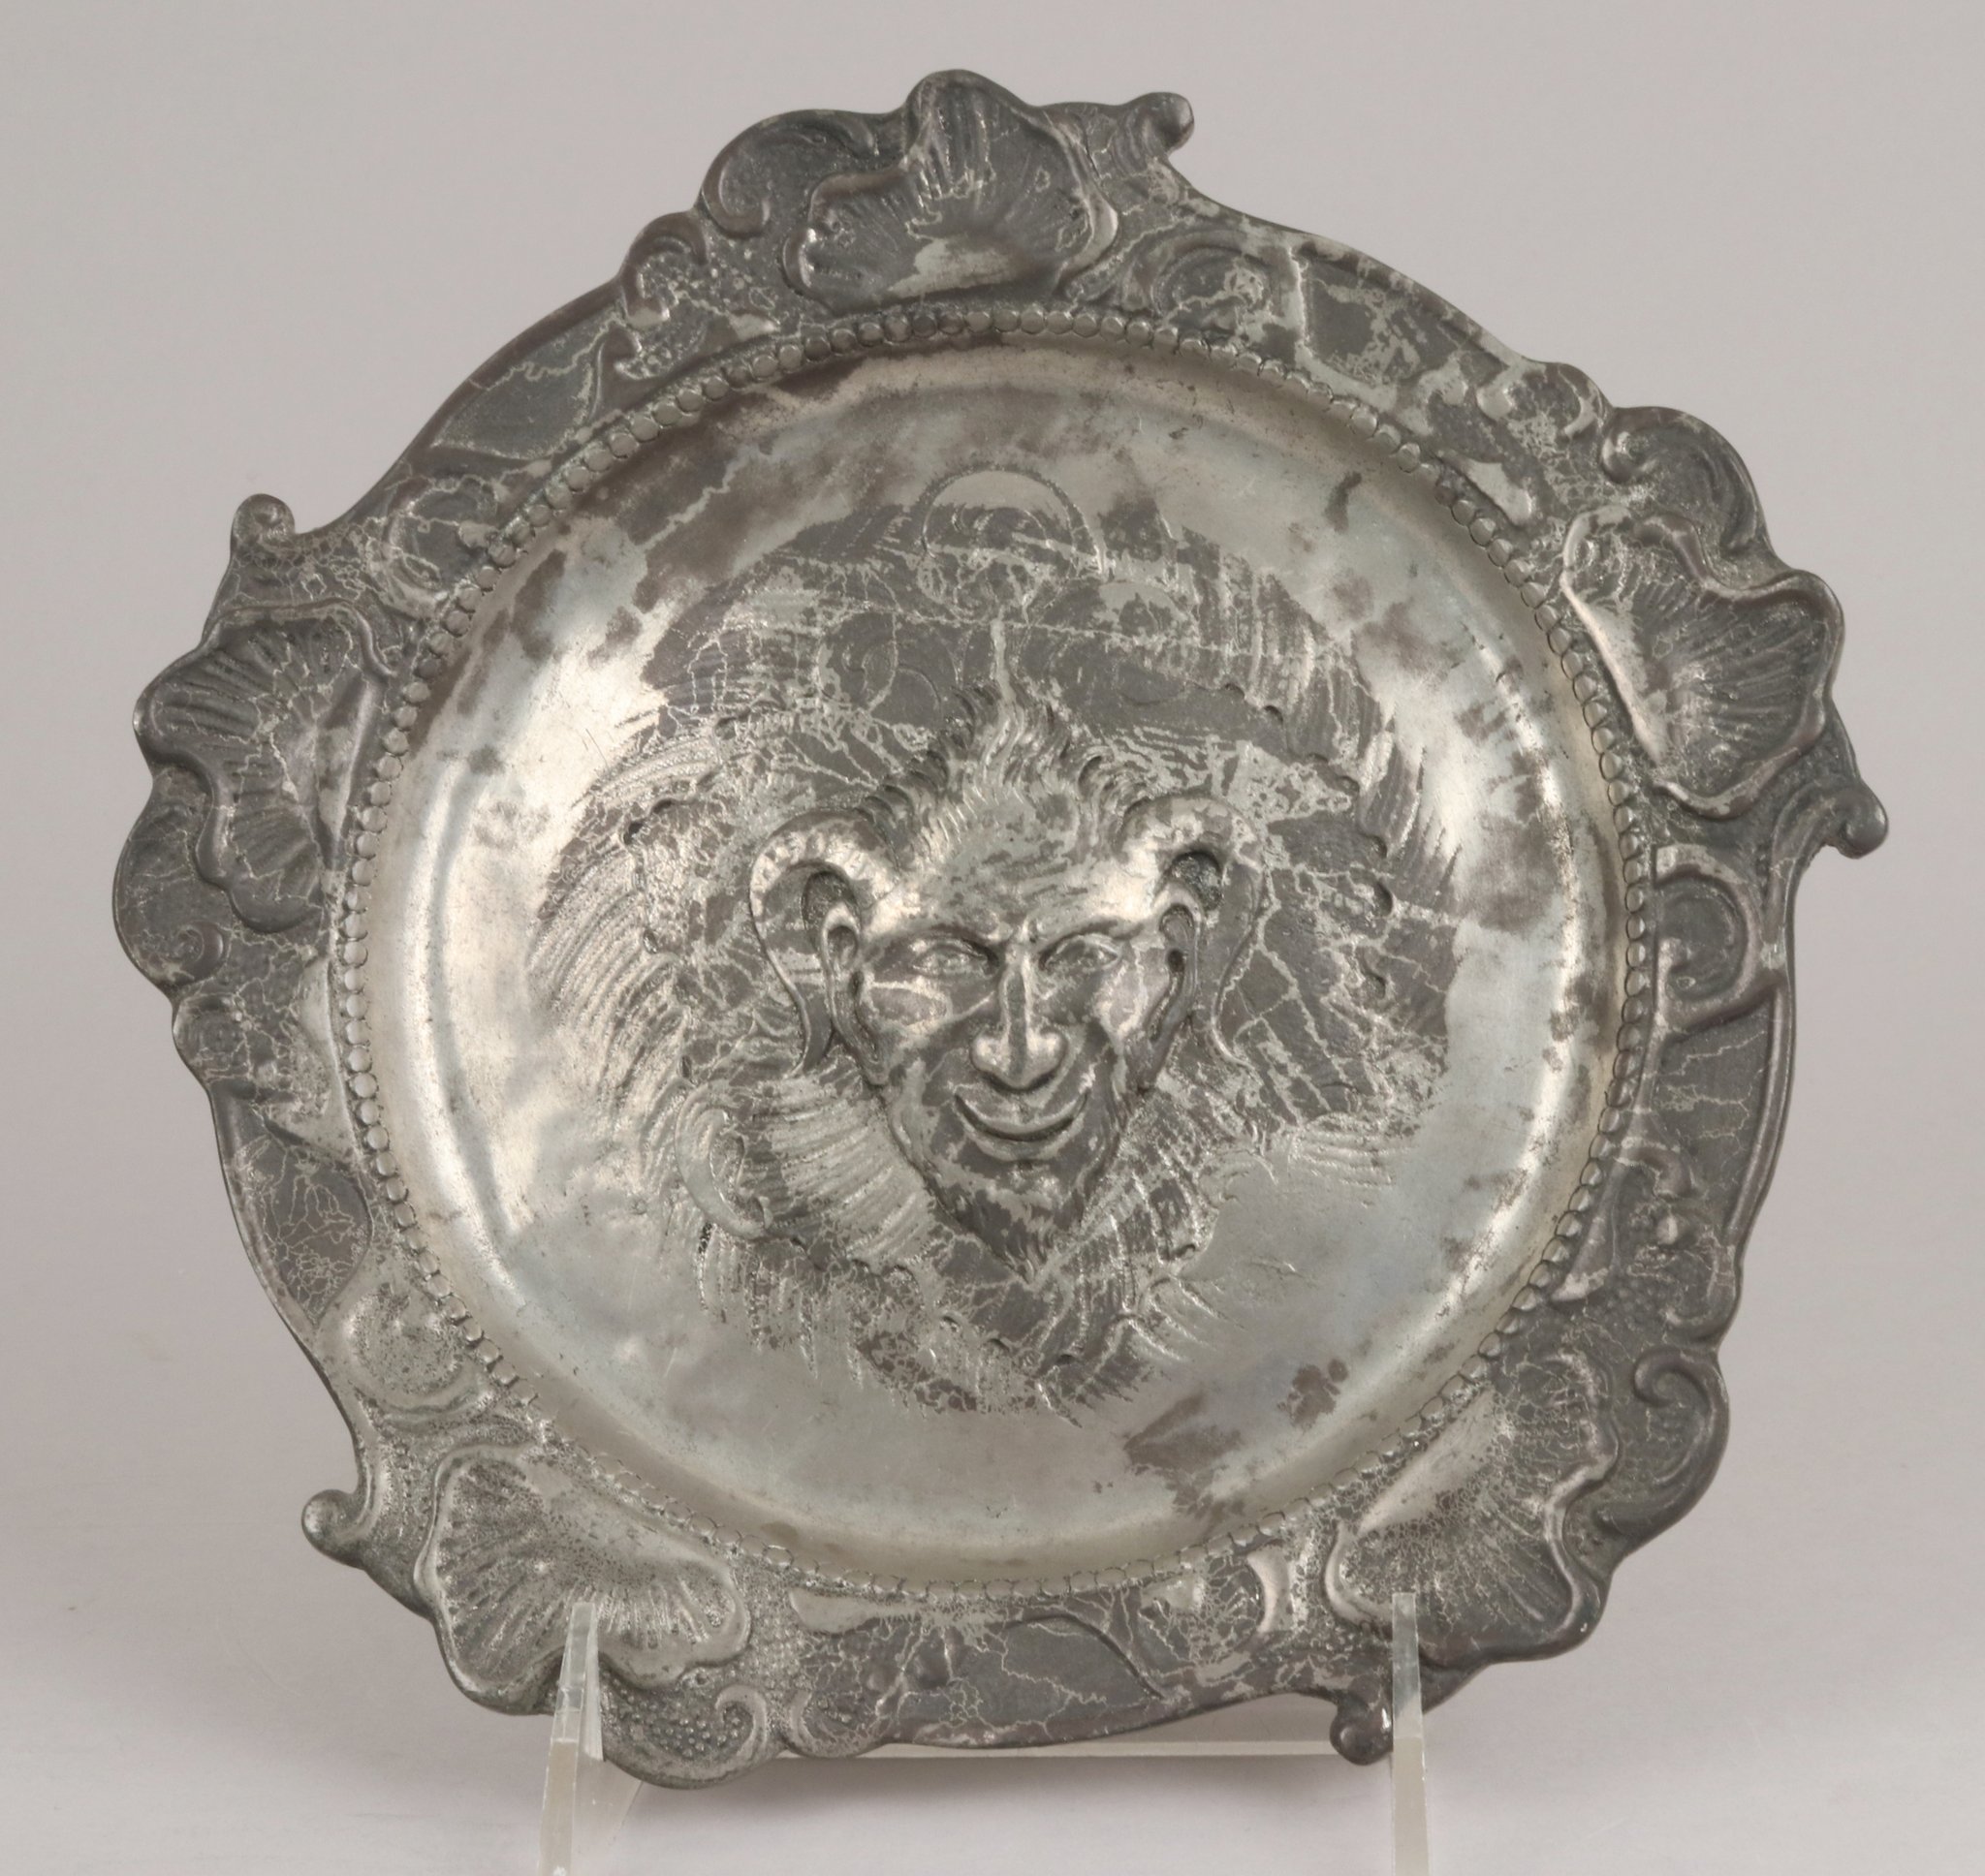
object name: salver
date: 1867-1900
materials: pewter